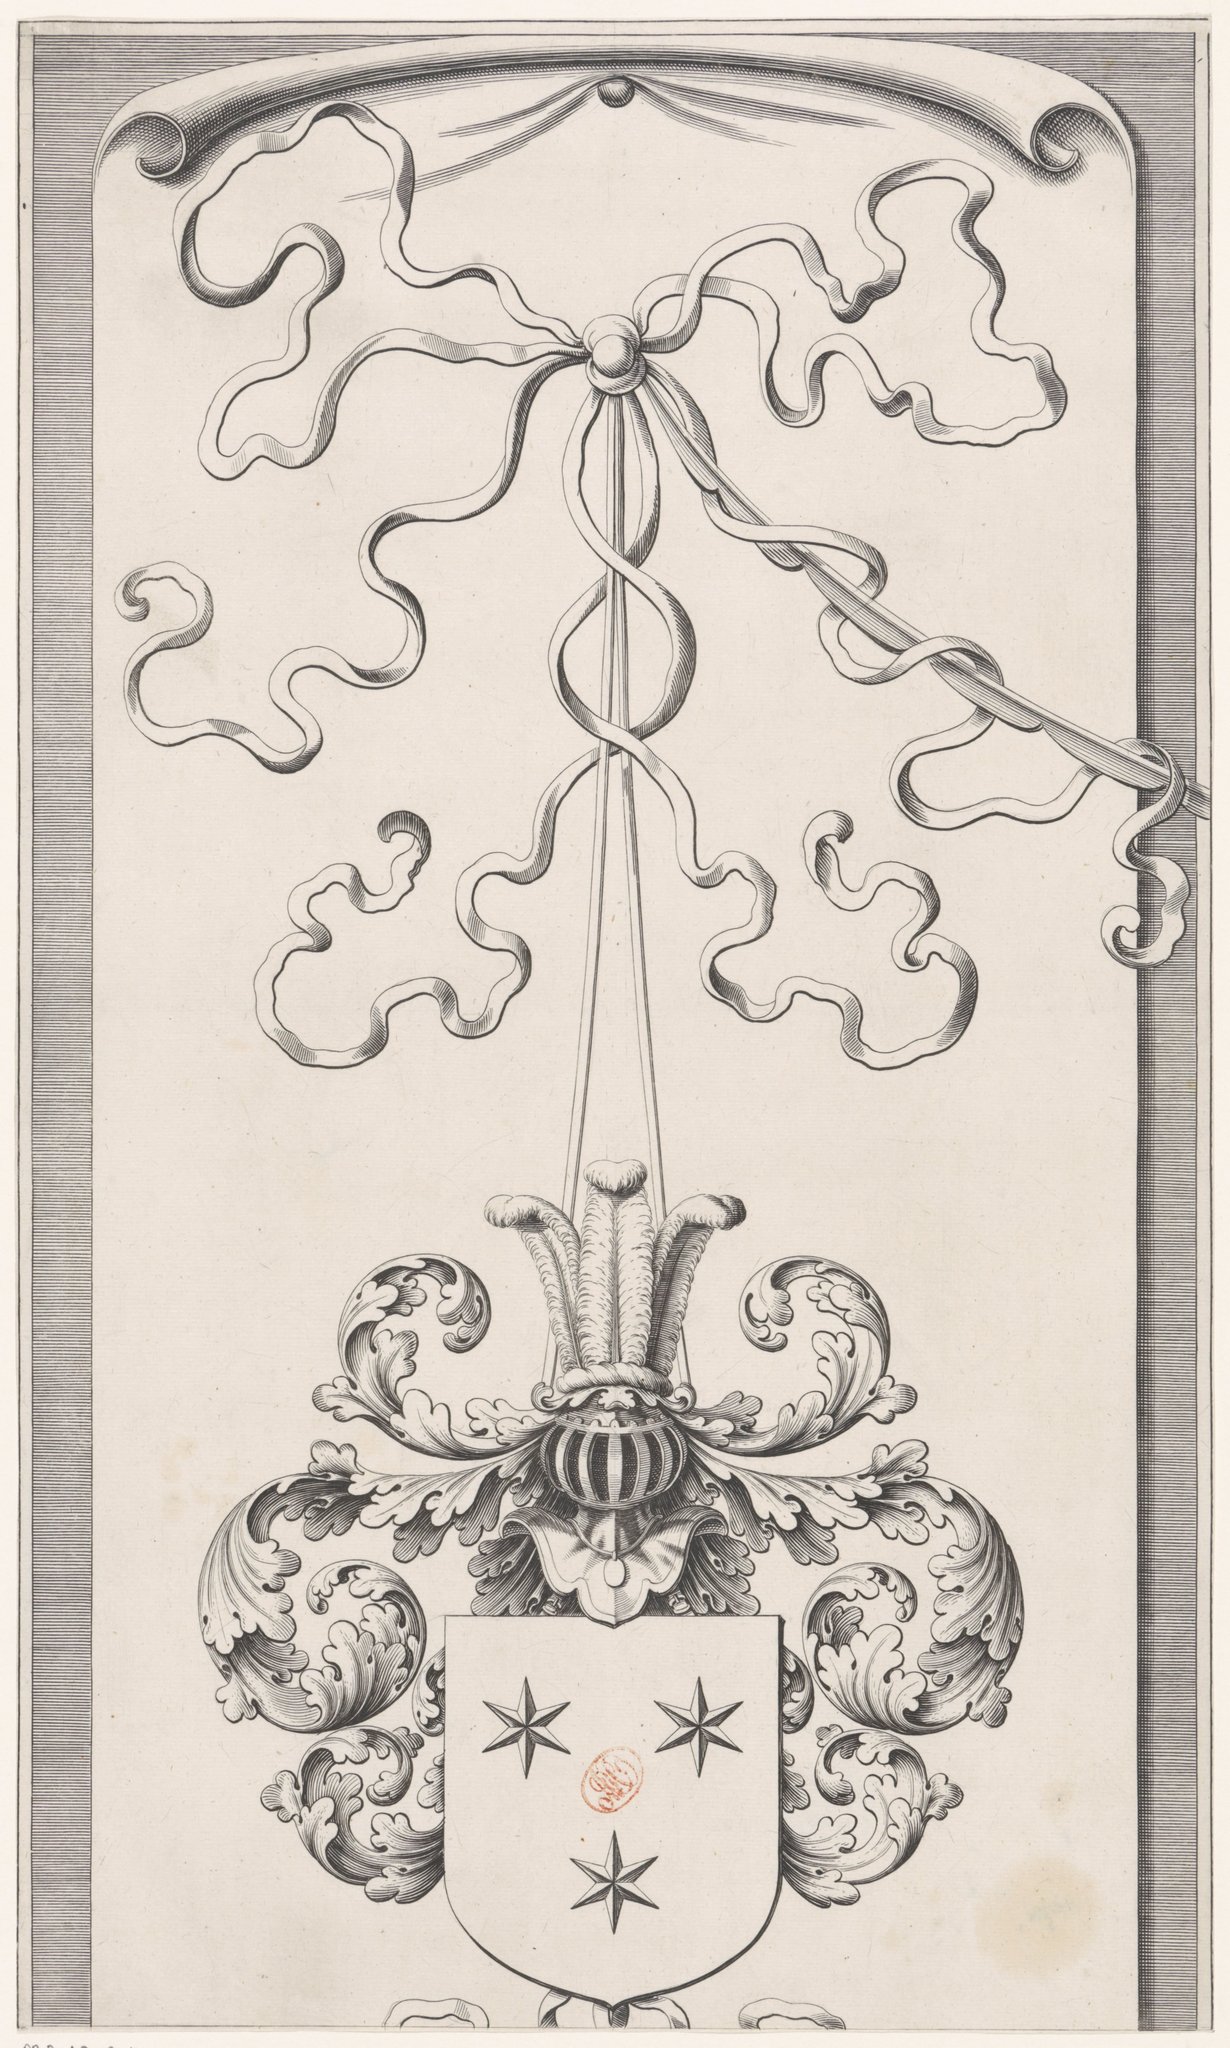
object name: print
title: Wapenschild van Johan van Berckel (II)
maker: johannes vinckboons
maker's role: draughtsman, print maker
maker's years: 1616-1670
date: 1660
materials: paper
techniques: engraving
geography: amsterdam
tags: mayor, armorial bearing, heraldry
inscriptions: collector's mark: Lugt 195, collector's mark: Lugt 2228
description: Deze prent is onderdeel van de rechter wapenrand van de eerste druk (1660) van 'Het Hooge Heemraedtschap van Schielandt', een negendelige kaart van het hoogheemraadschap van Schieland. Van deze kaart zijn voor zover na te gaan zes verschillende drukken bekend, uit respectievelijk 1660, 1684, 1694, 1710, 1718 en 1765. Het hoogheemraadschap gaf in 1650 opdracht tot het maken van de kaart. De wapens van de toen zittende dijkgraaf, vijf hoogheemraden en rentmeester/secretaris staan daarom op de kaart, die echter pas in 1660 werd voltooid en voor het eerst uitgegeven. Slechts de dijkgraaf en één hoogheemraad zaten toen nog in het bestuur. Vermoedelijk werd daarom bij de eerste druk een wapenrand met de wapens en namen van de vier overige hoogheemraden en de rentmeester/secretaris en een schild met alle namen van de dijkgraaf en hoogheemraden uit 1650 en 1660 toegevoegd. De huidige prent is onderdeel van de wapenrand van deze eerste druk. Voor de tweede druk van de kaart werd slechts één plaat bijgewerkt. Verondersteld wordt dat vervolgens voor de derde, vierde en vijfde druk de platen onveranderd bleven. Wel werd voor iedere uitgave een nieuwe wapenrand gedrukt met de wapens en namen van de toen zittende bestuursleden van het hoogheemraadschap. In 1765 werden de platen van de kaart, op één na, allen bijgewerkt. Voor de linker wapenrand, zie RP-P-AO-13-3Y. Voor een exemplaar van de tweede (1684), derde (1694), vierde (1710) of vijfde (1718) druk van de kaart, zie RP-P-AO-13-3X.